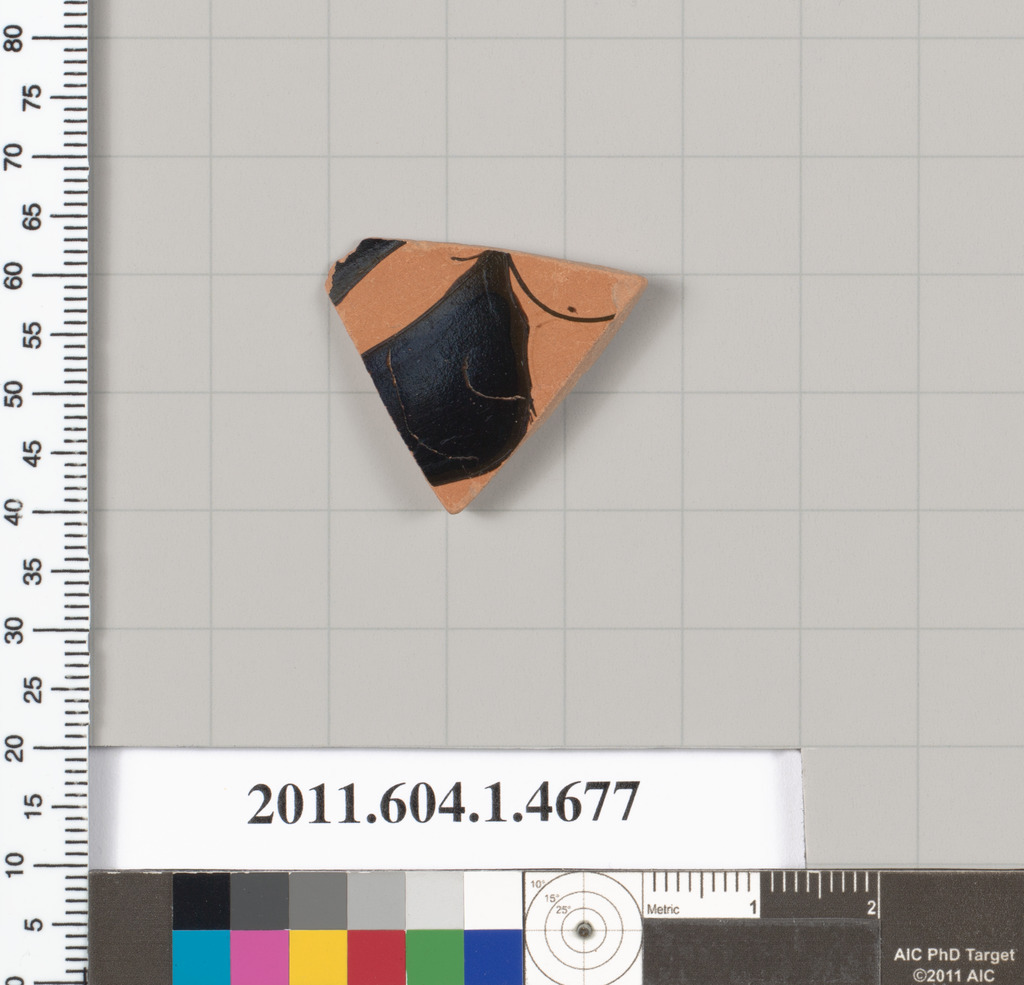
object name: kylix fragment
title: Terracotta fragment of a kylix (drinking cup)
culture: greek, attic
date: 500-480 BCE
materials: terracotta